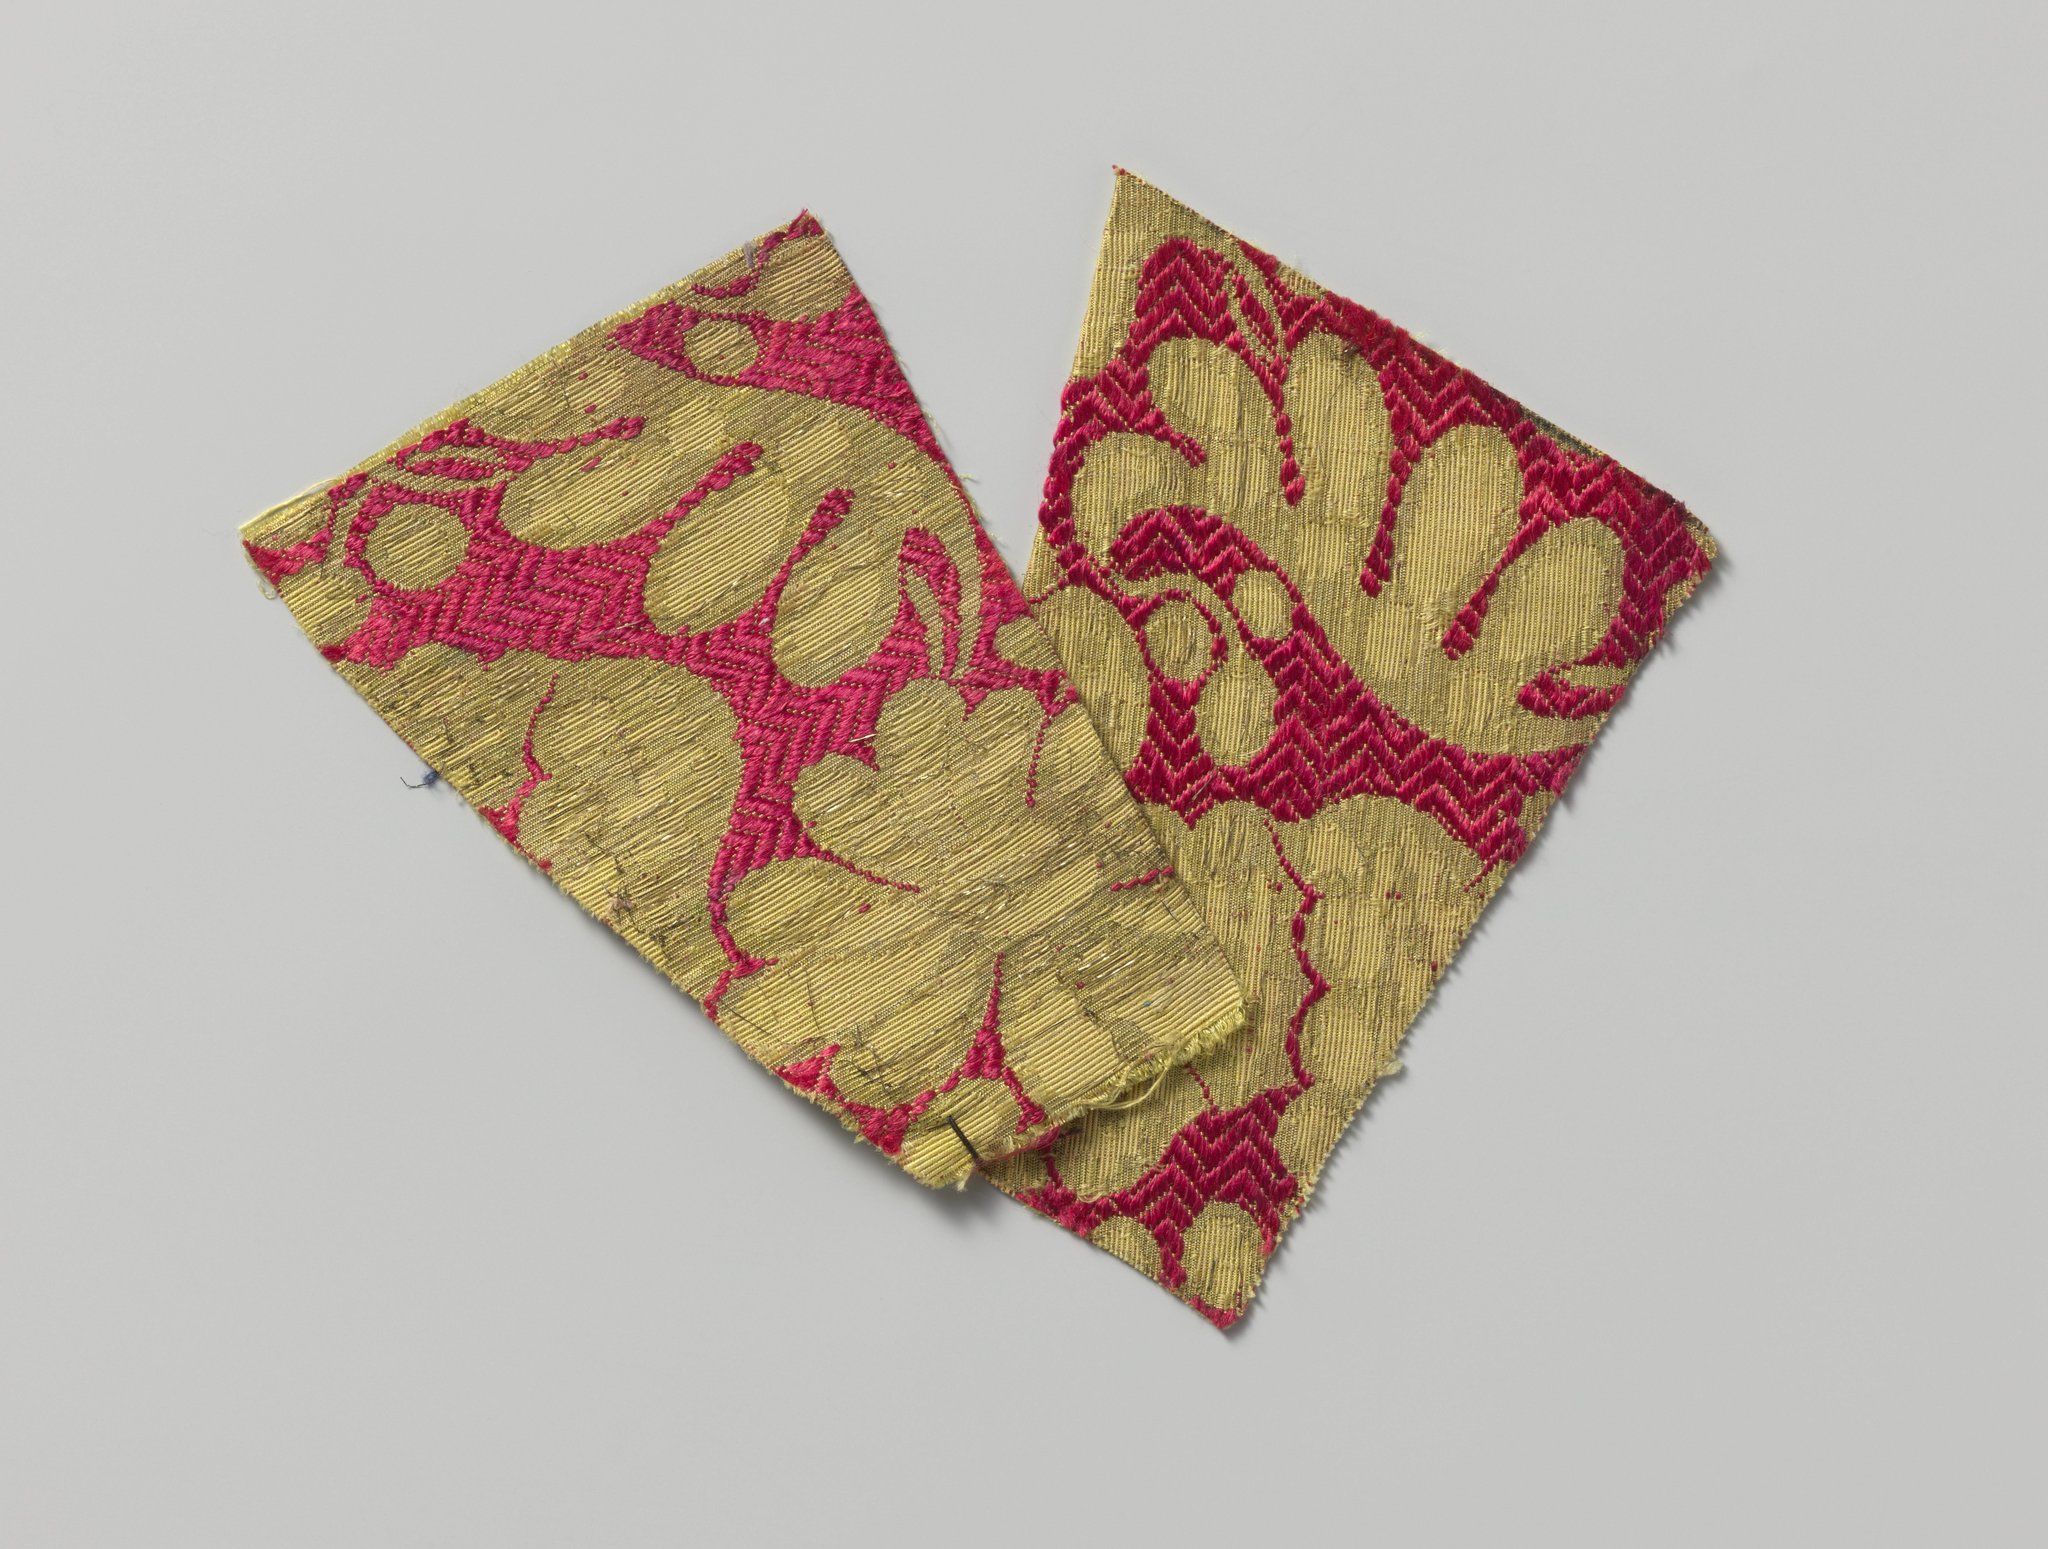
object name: fragment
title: Twee fragmenten zijde lampas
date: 1700-1799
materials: cotton, silk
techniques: lampas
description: Fragment oosterse textiel. Het fragment heeft gouden bloemen en bladeren op een rode grond.